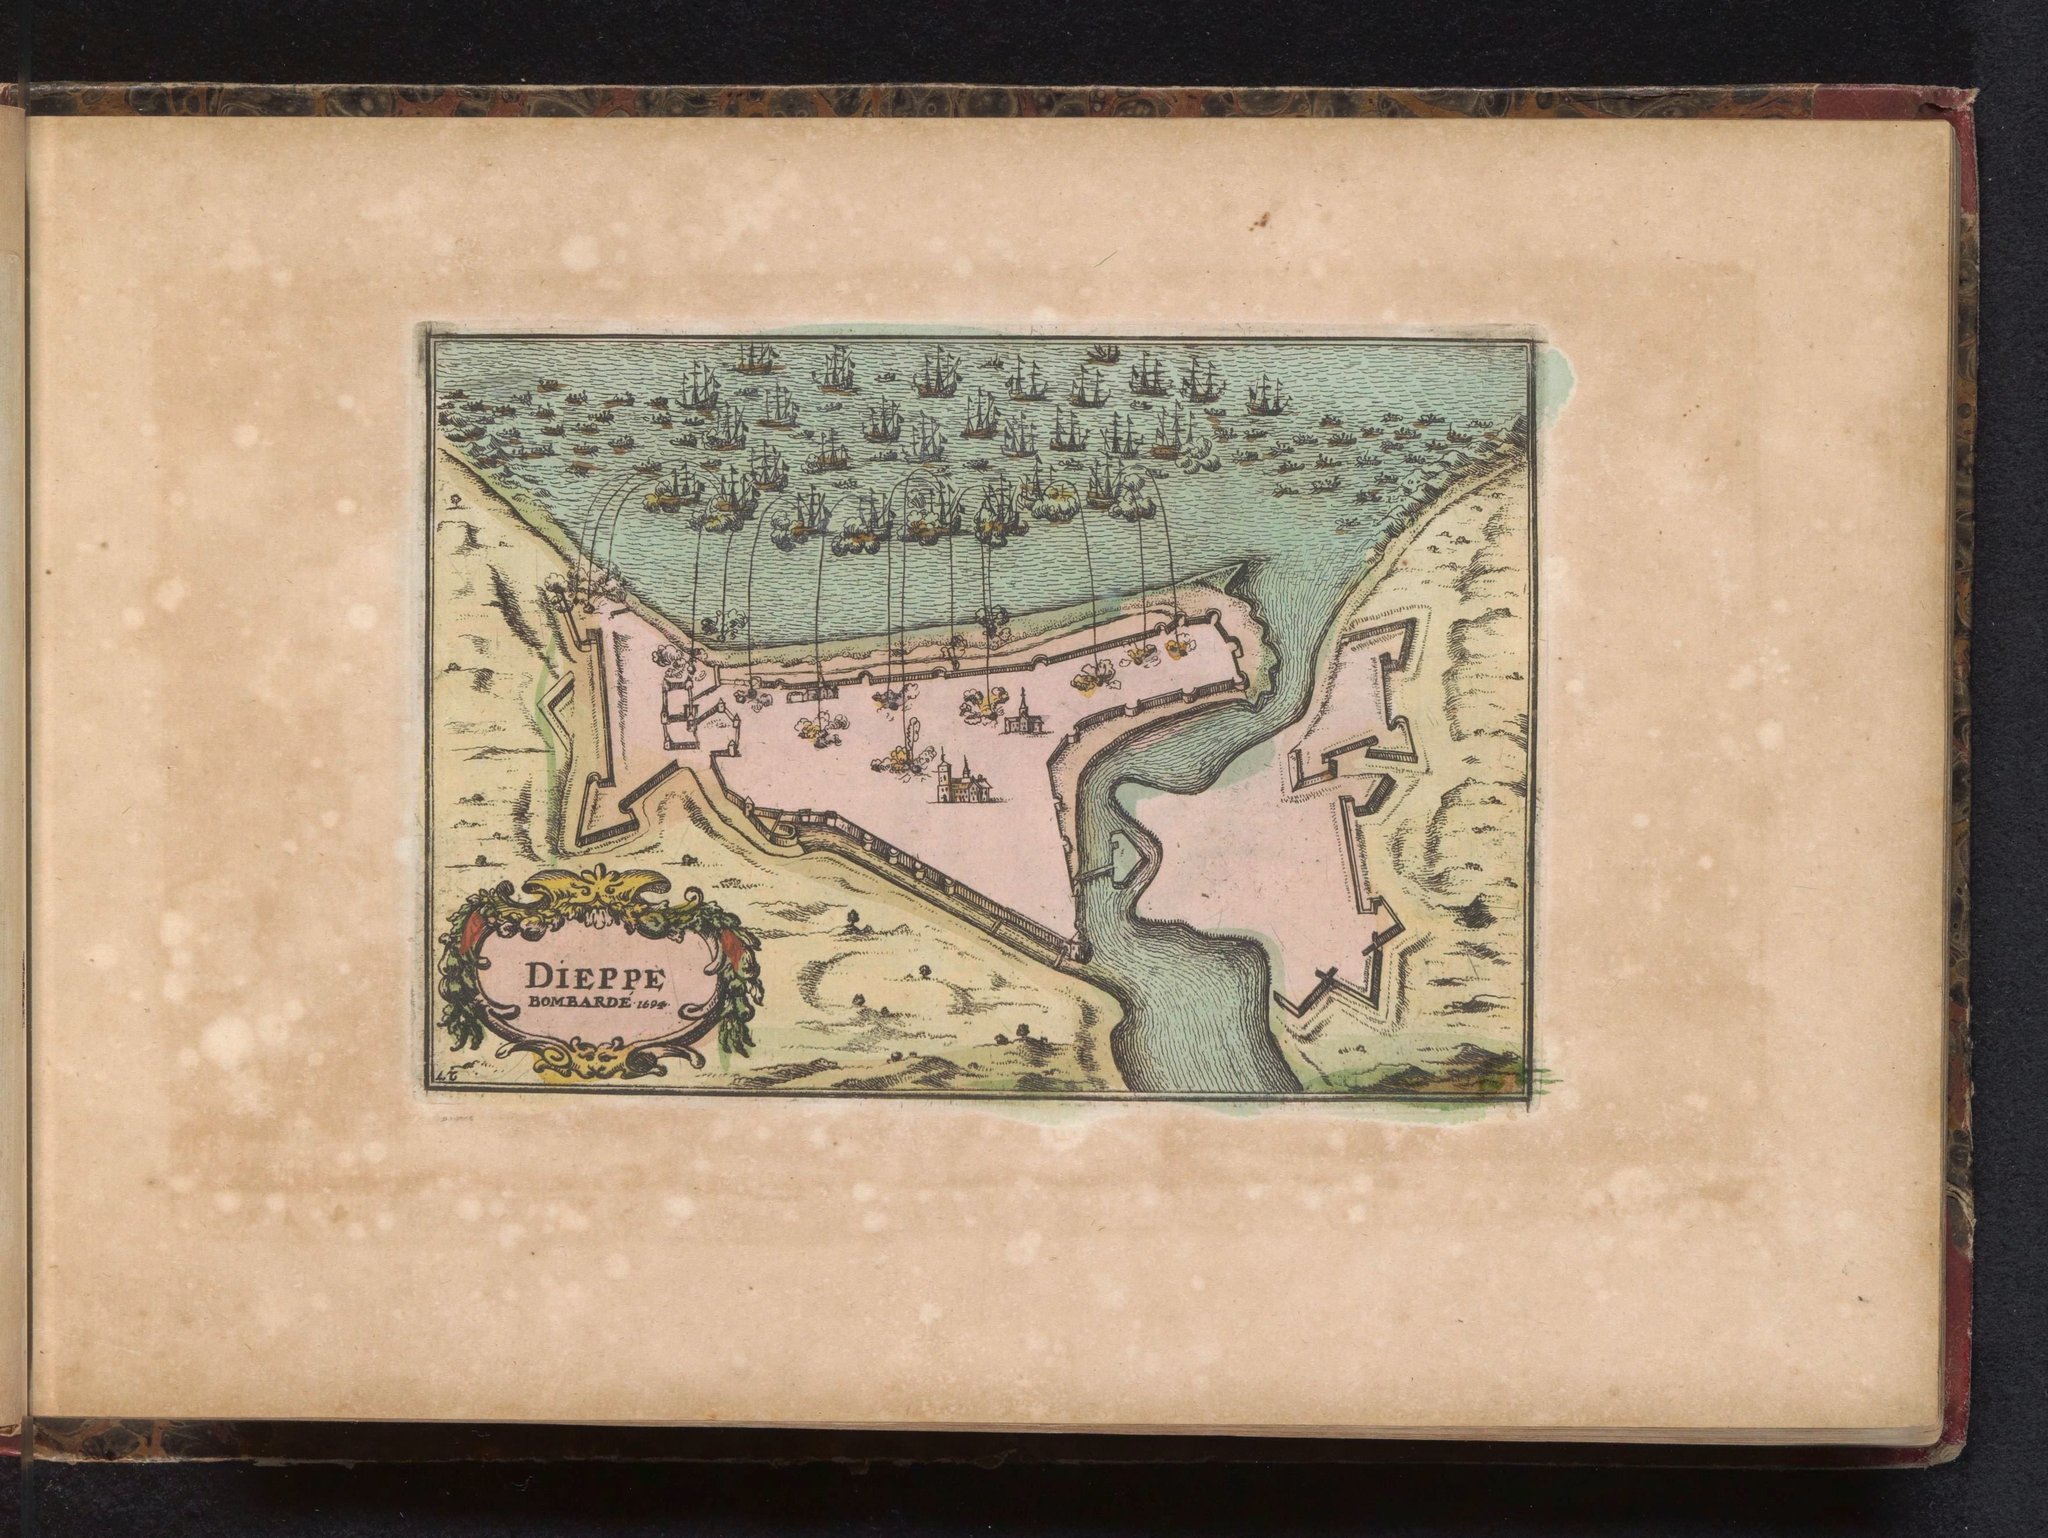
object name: print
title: Dieppe Bombardie 1694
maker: Anonymous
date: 1700-1702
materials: paper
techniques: etching, hand coloring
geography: amsterdam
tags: maps of cities, bombardment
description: Bombardement van de Franse havenplaats Dieppe door de gecombineerde Engelse en Hollandse vloot, juli 1694. Onderdeel van een atlas met 223 kaarten van landen en steden en oorlogstaferelen in Europa in de periode ca. 1690-1735.